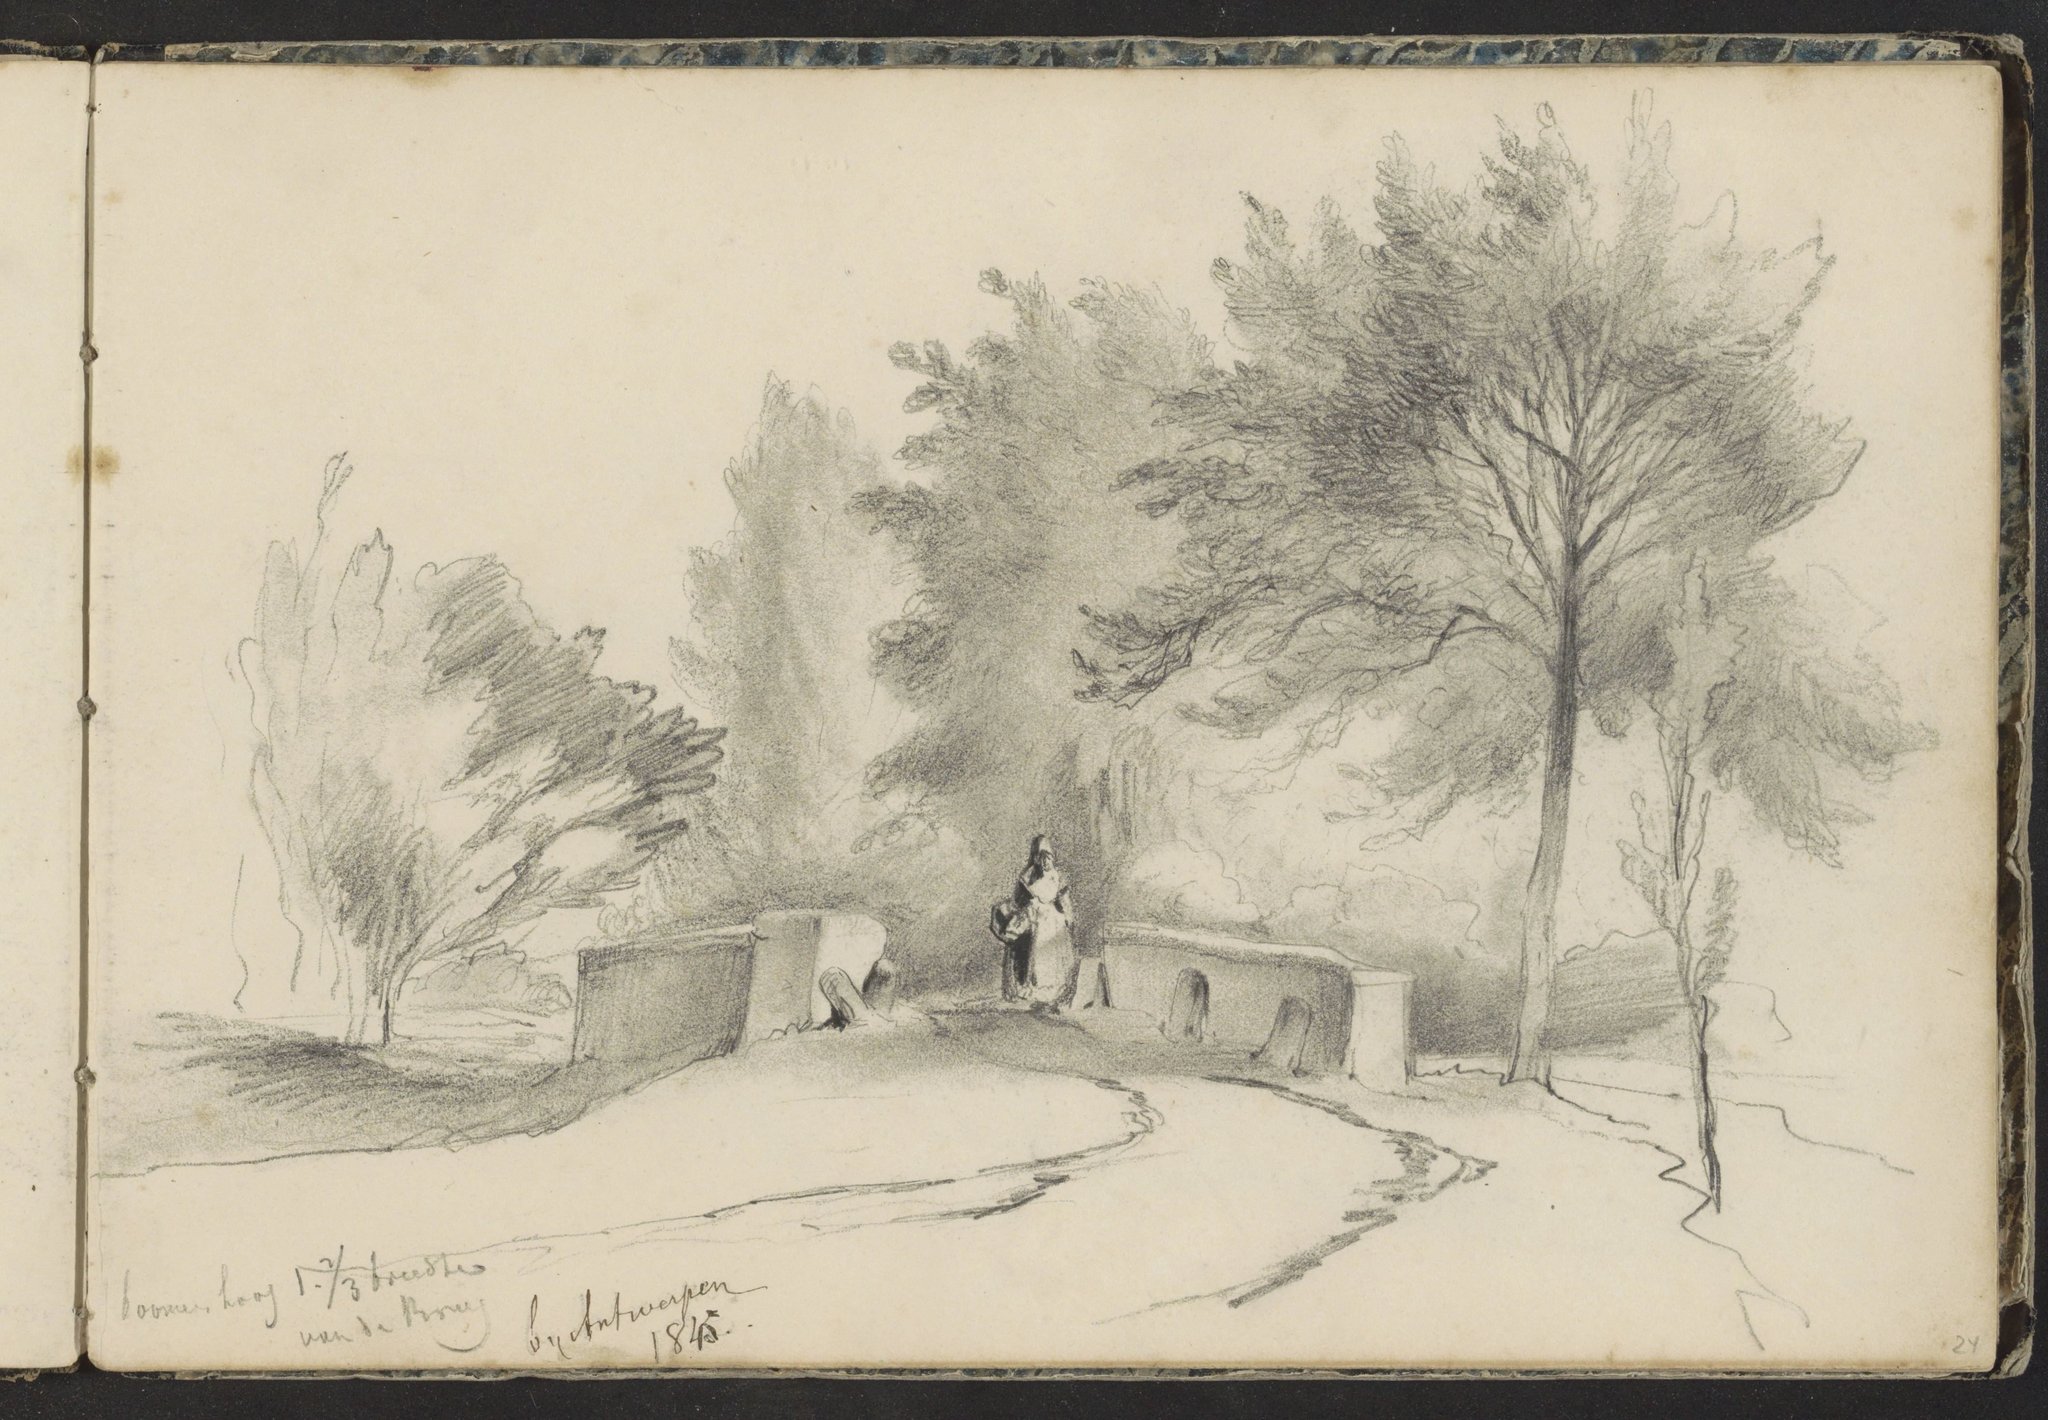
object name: sketchbook leaf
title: Vrouw op de brug van een boomrijk pad bij Antwerpen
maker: johannes tavenraat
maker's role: draughtsman, painter, print maker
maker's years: 1809-1881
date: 1845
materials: paper, pencil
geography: antwerp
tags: trees, road, path, bridge, landscapes (+ landscape with figures, staffage), antwerp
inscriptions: date and inscription: ‘bomen hoog 1/3 breedte/ van de Brug/ bij Antwerpen/ 1845-’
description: Blad 24 recto uit een schetsboek met 44 bladen.